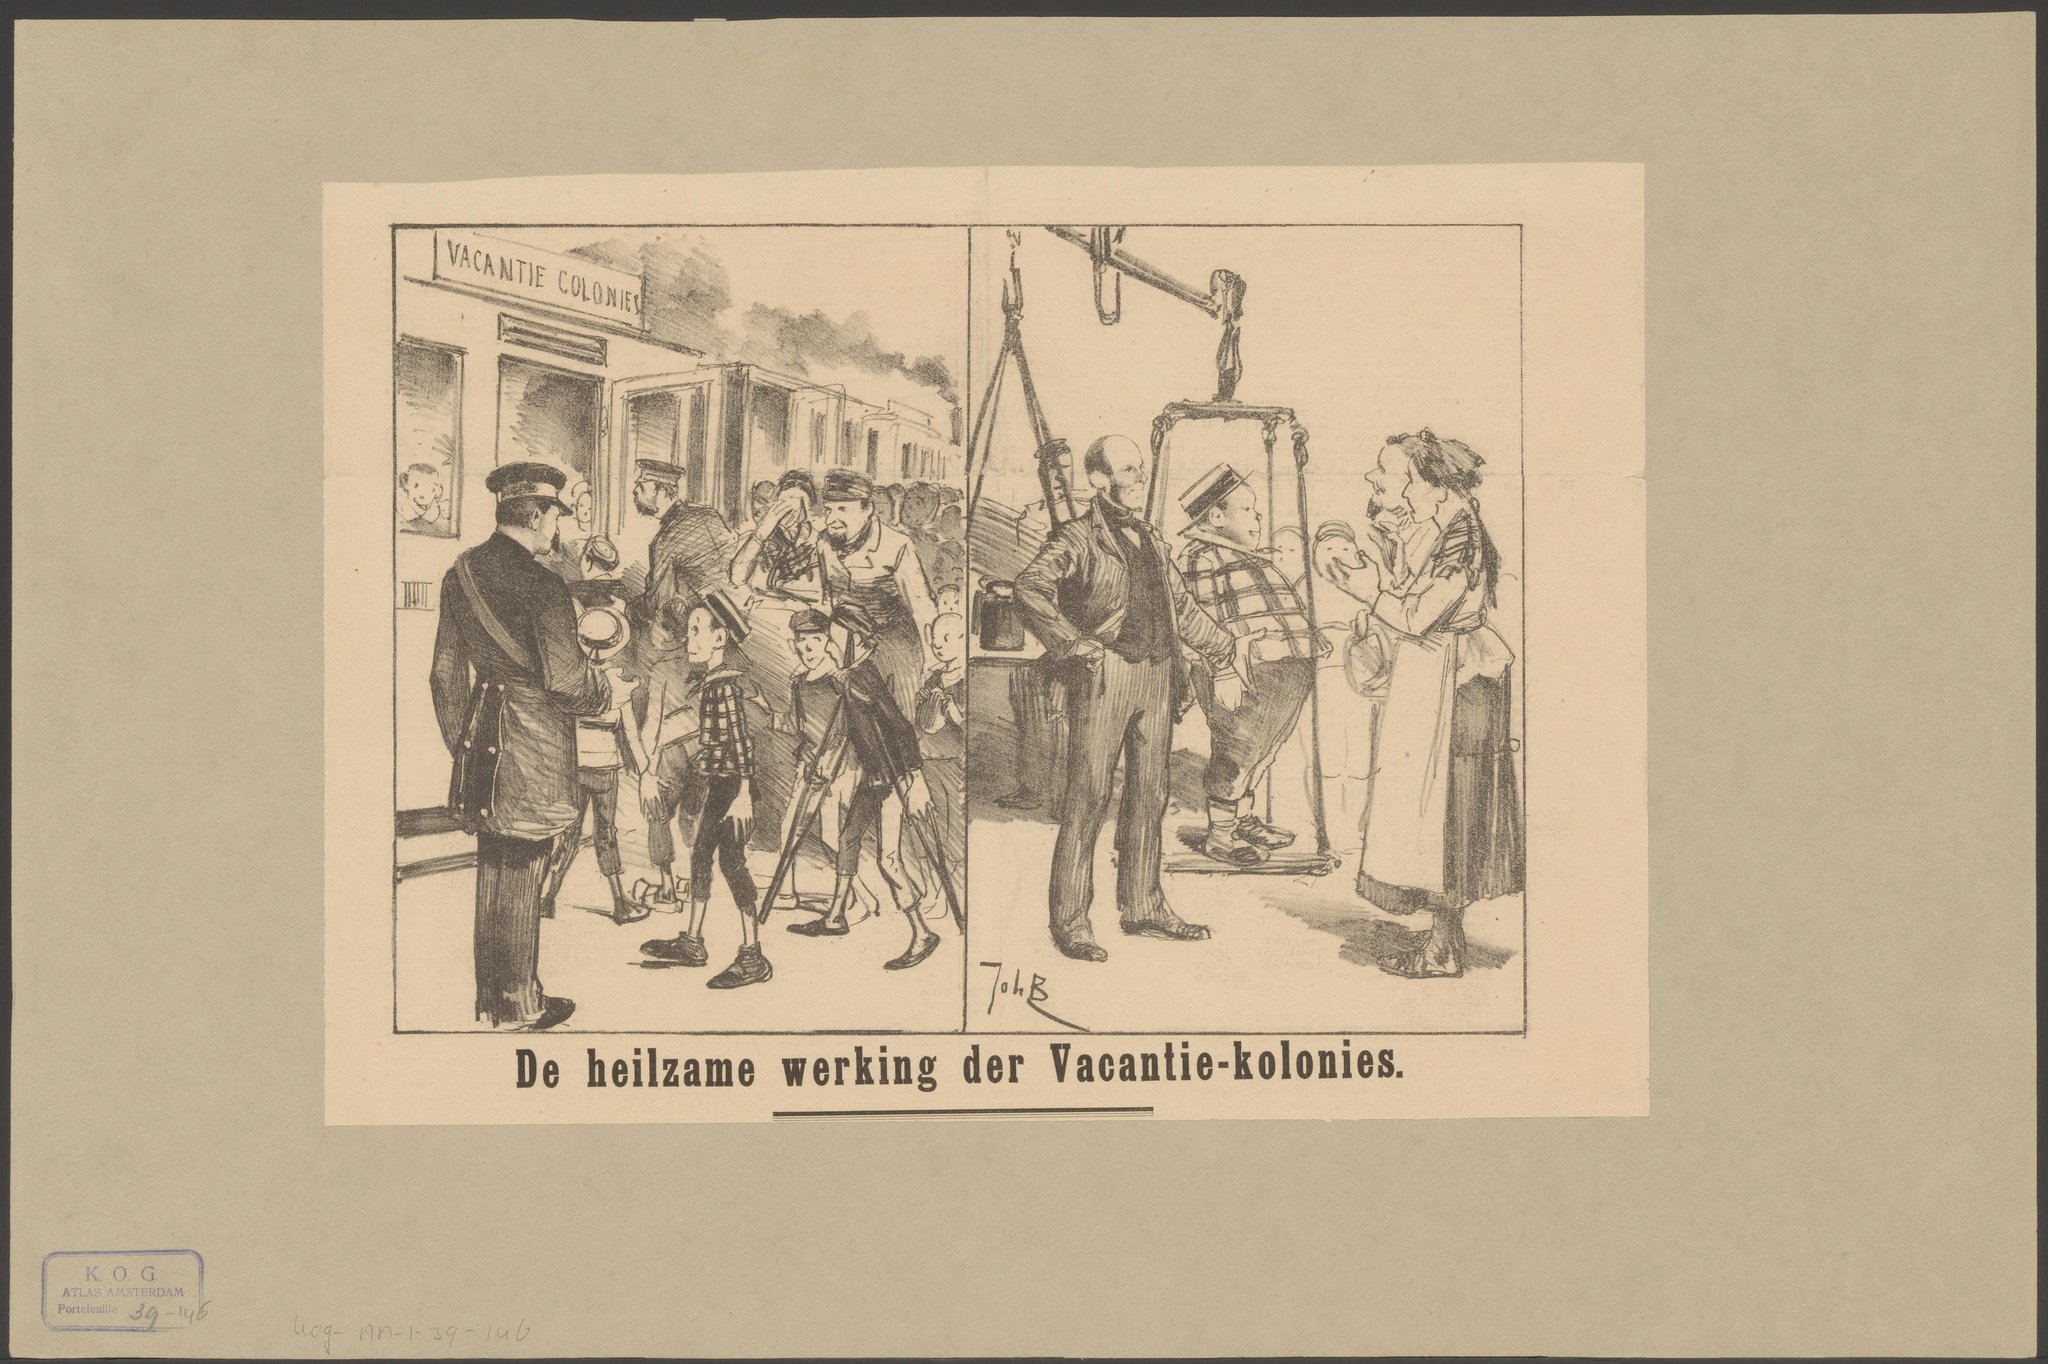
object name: cartoon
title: De heilzame werking der Vacantie-kolonies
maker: johan braakensiek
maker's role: draughtsman, print maker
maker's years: 1858-1940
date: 1890-1900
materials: paper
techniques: letterpress printing, lithograph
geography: netherlands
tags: boy (child between toddler and youth), scales, fat and thin (human types)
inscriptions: collector's mark: Lugt 1641b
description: Onderwerpsrubriek binnen de Atlas Amsterdam: Armwezen en liefdadige instellingen: IV. Prenten betrekking hebbende op Philantropie.